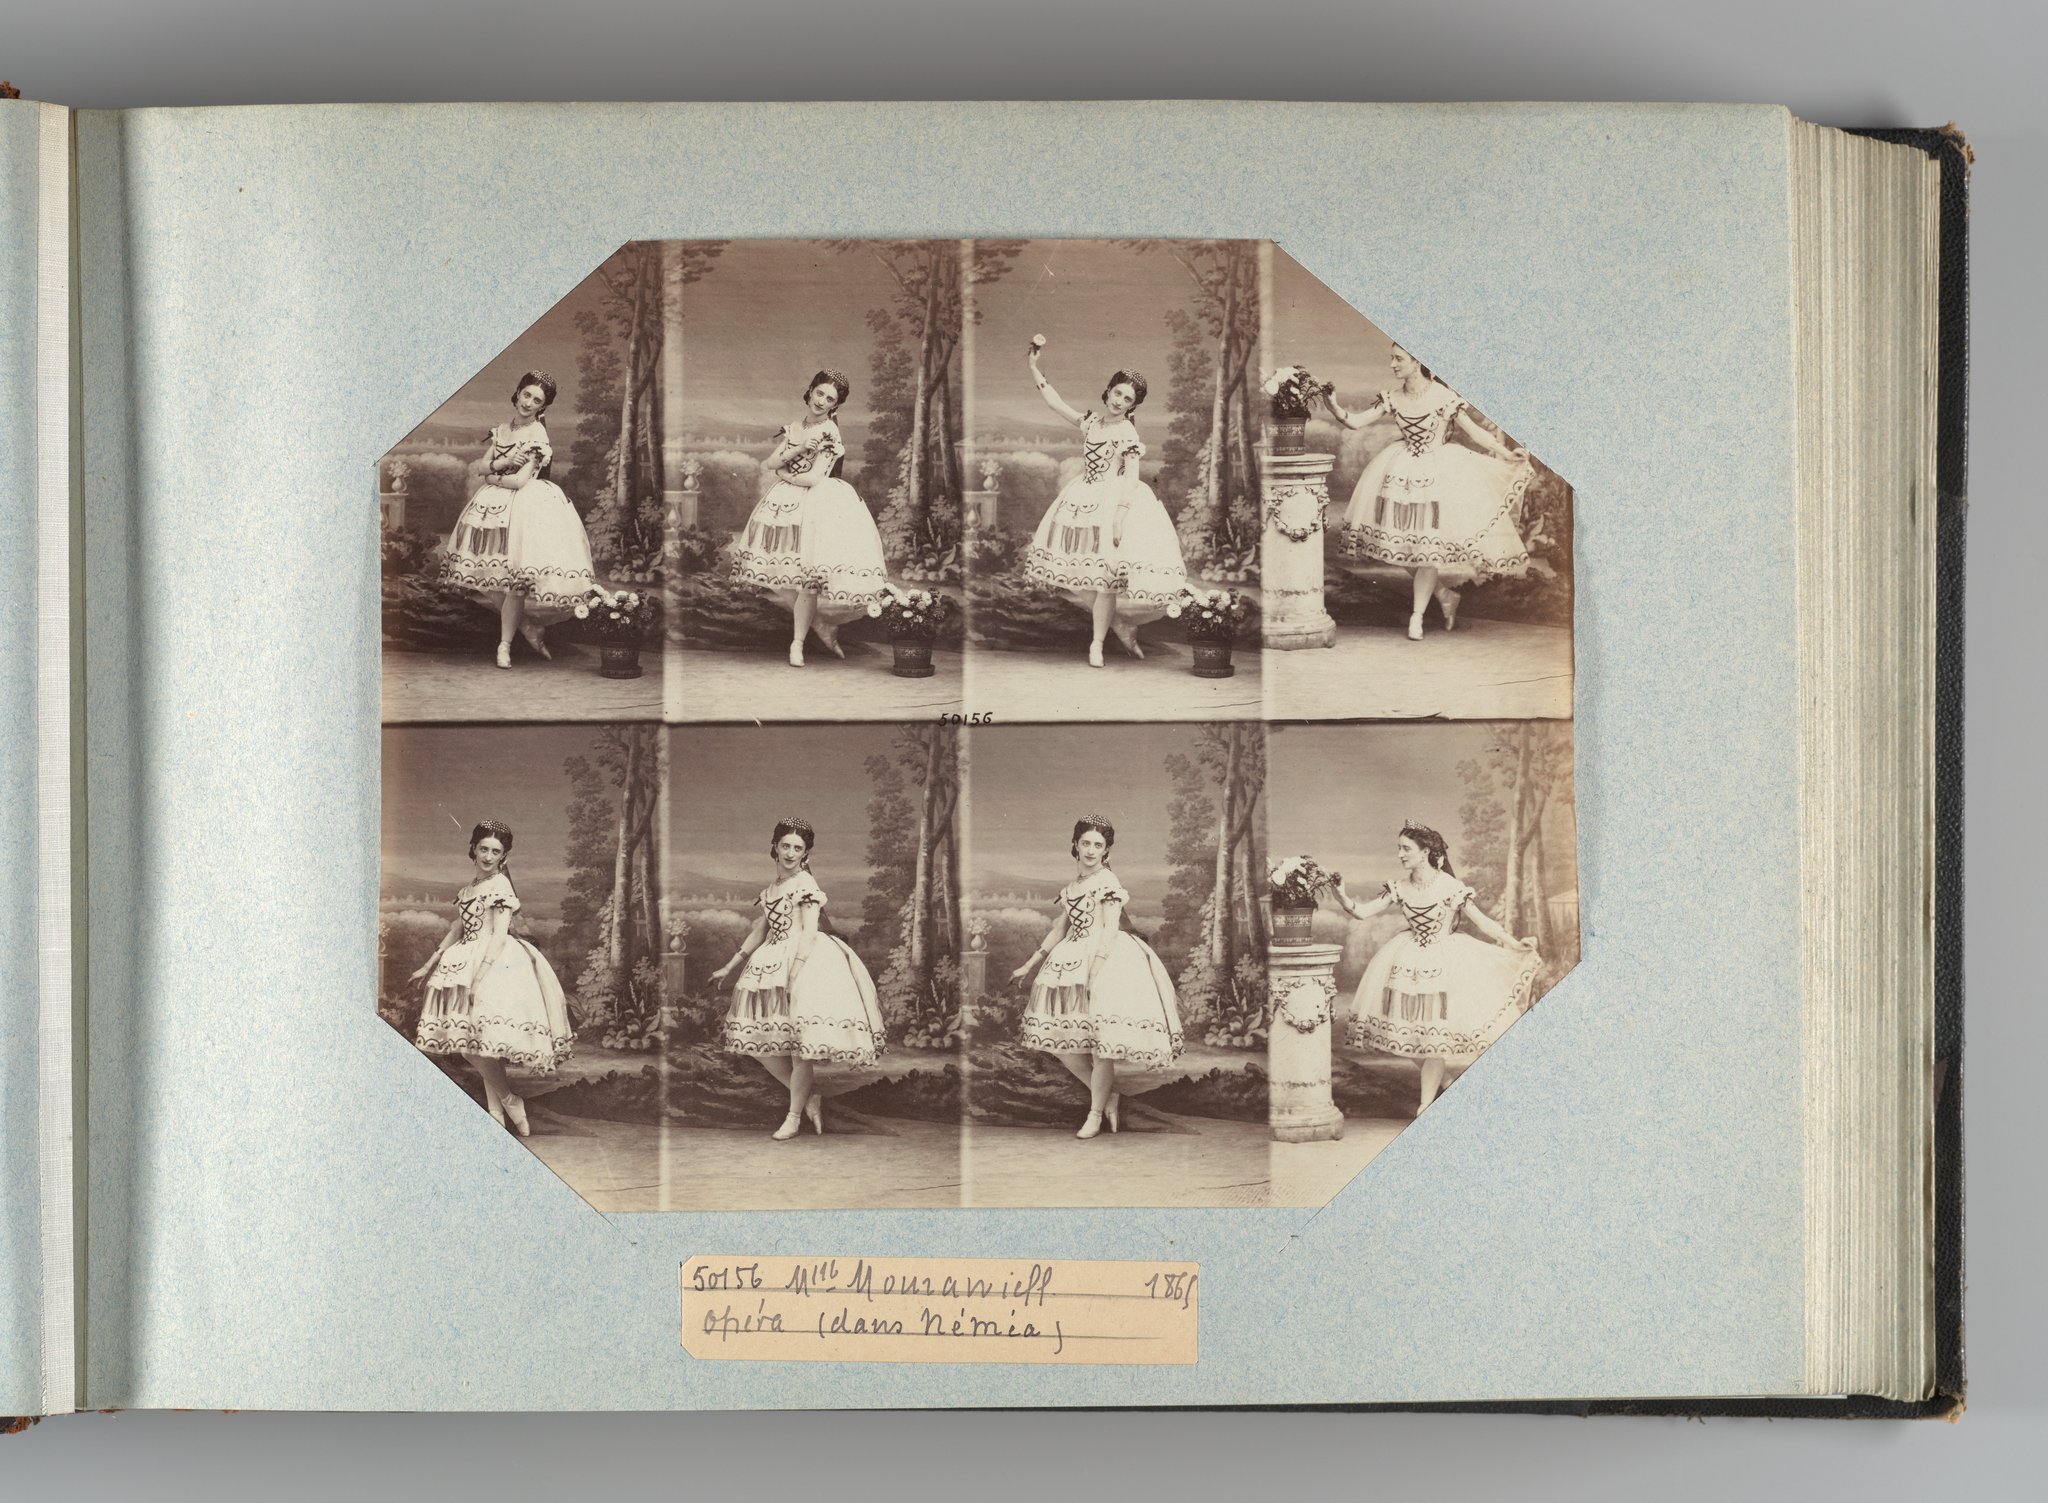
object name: photograph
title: Mlle Mourawieff dans Néméa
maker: andré-adolphe-eugène disdéri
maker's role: artist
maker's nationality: french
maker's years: 1819-1889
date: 1863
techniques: albumen silver print, glass negative